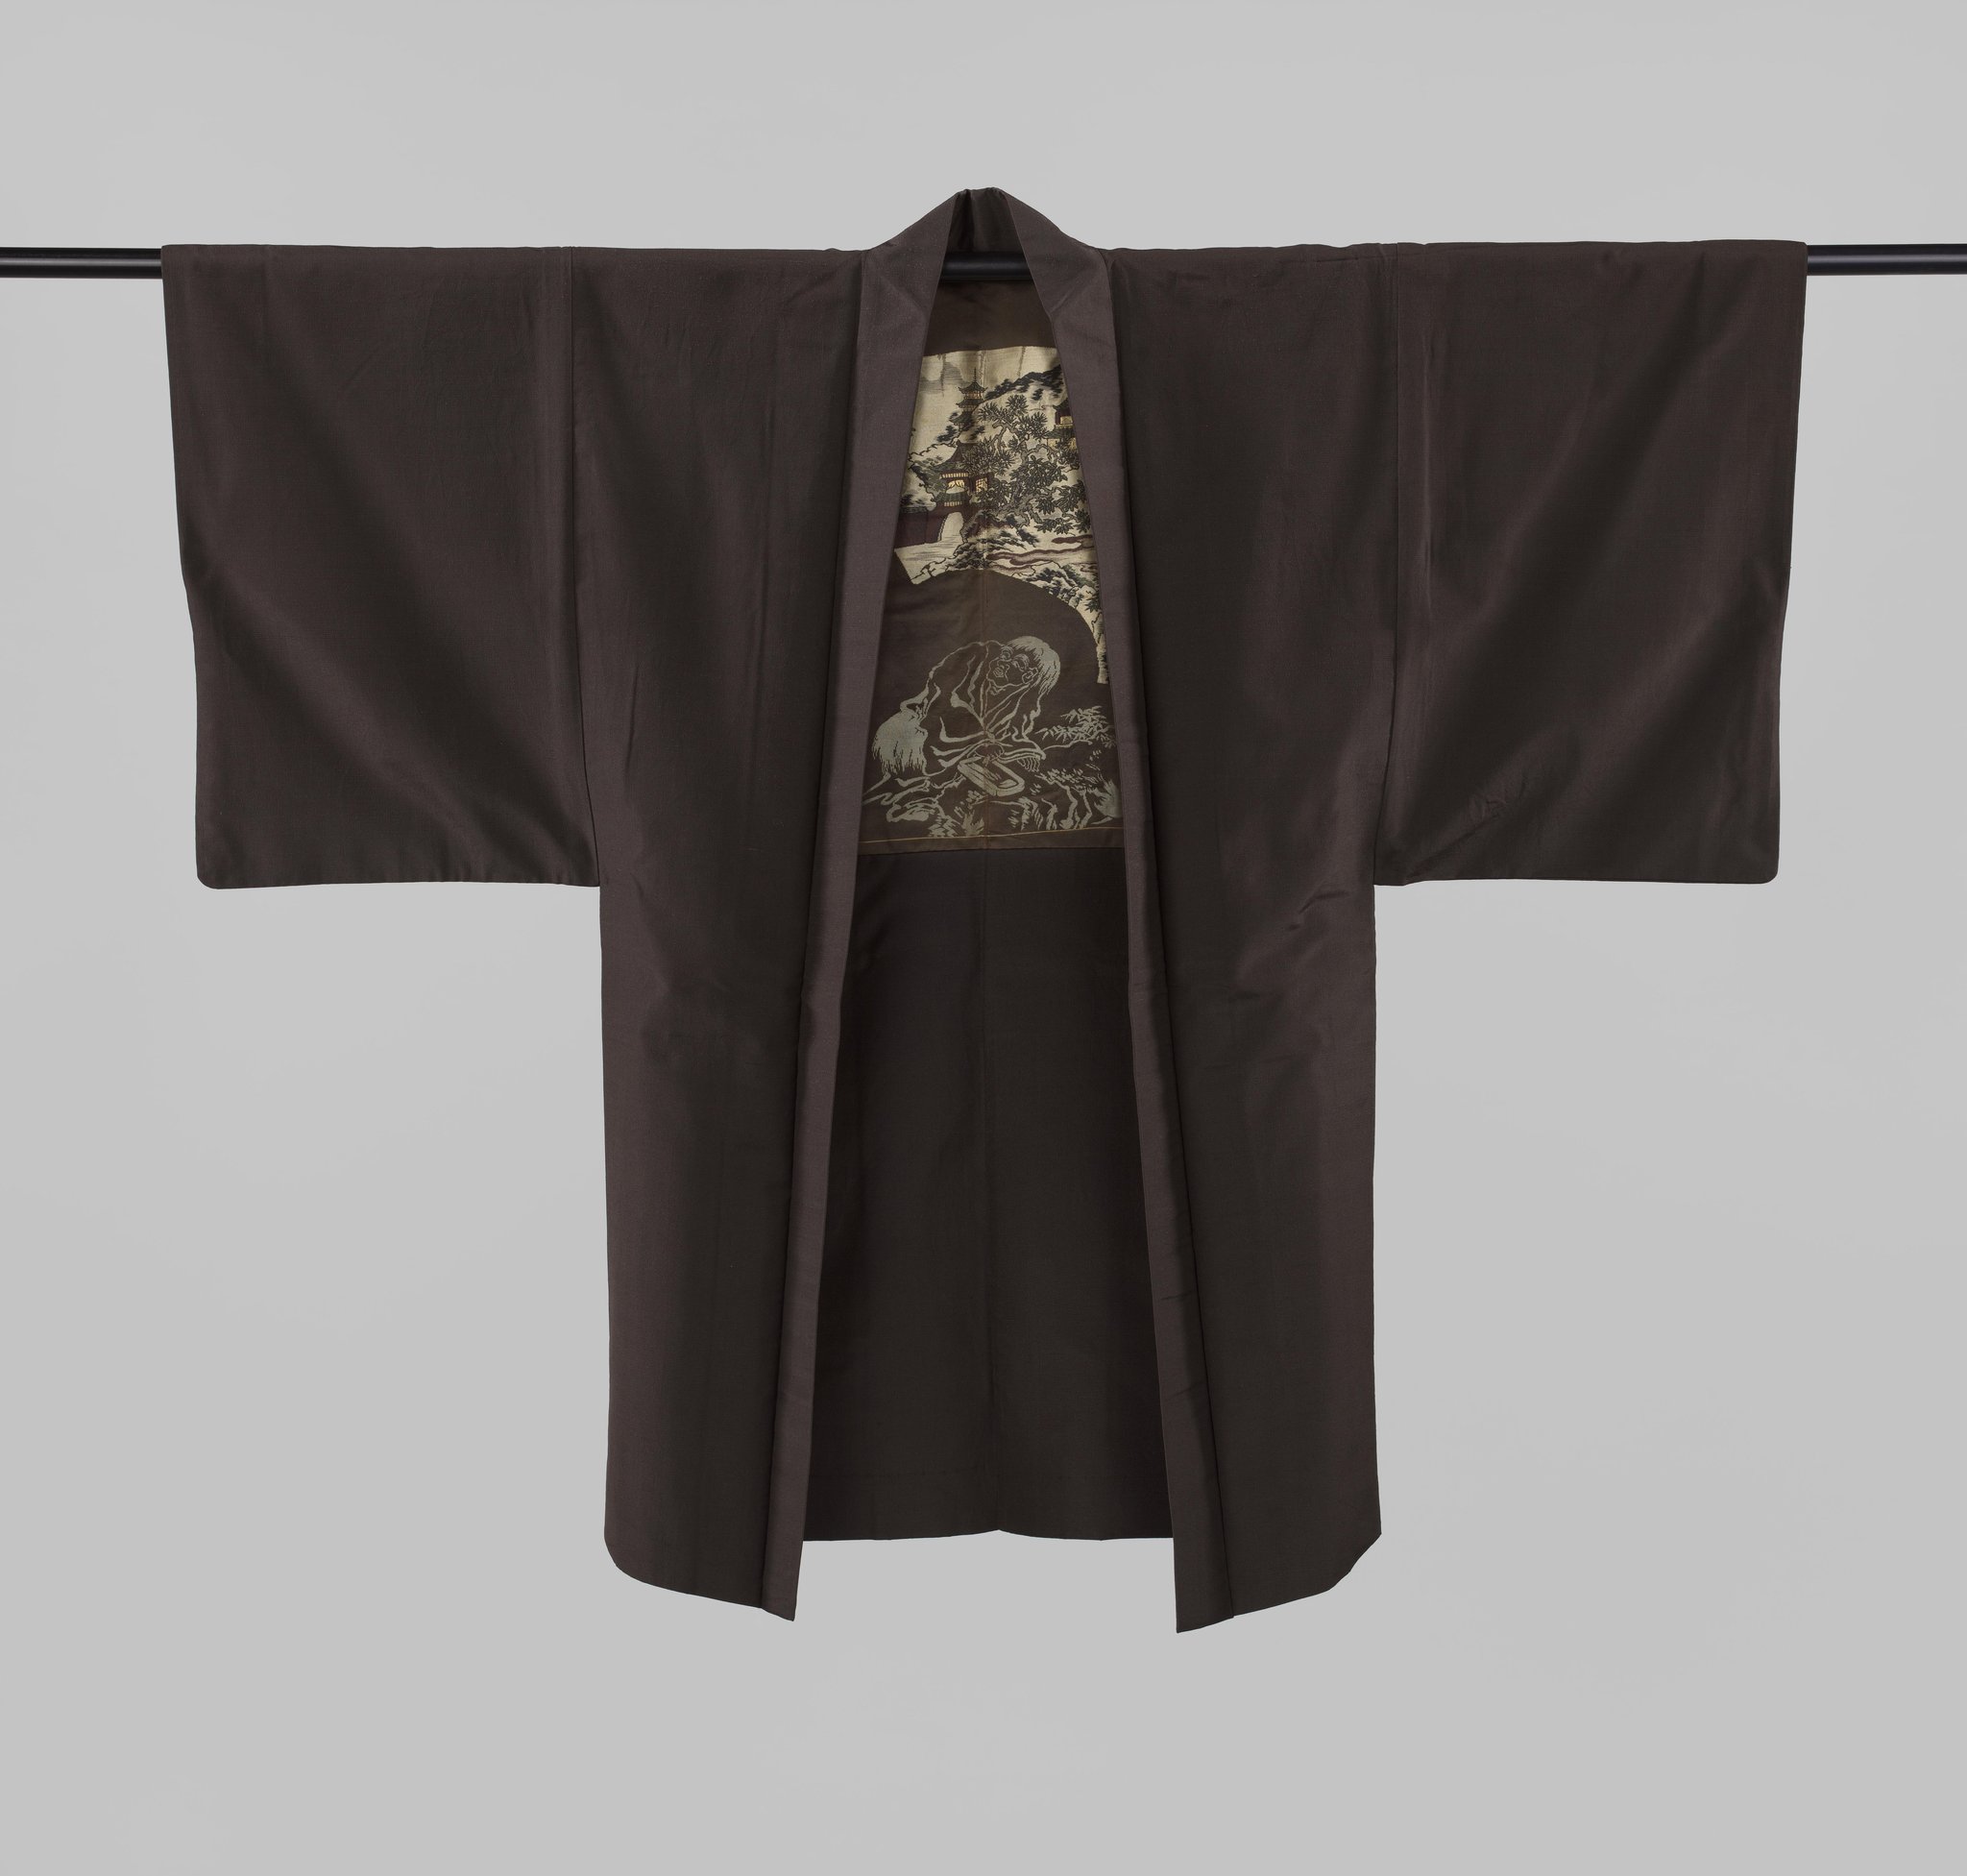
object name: kimono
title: Mannen haori met Wan Zixhi, Wan Xianzhi en het Orchidee Paviljoen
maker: Anonymous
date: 1920-1940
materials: silk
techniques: weave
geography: japan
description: Haori voor een man met een versiering op de voering van een landschap met paviljoens en een brug over een stroom in de bergen, in imitatie van een vouwwaaierschildering, met links daarvan twee figuren, de een (Xianzhi) inkt wrijvend in een inksteen op een rots, de ander (zijn vader, Zixhi) schrijvend met een penseel op een verticaal stuk rots. Wan Zixhi was een Chinese calligraaf uit de 4de eeuw, beroemd om zijn Lan Ting Xu, Voorwoord bij de verzameling gedichten geschreven in het Orchidee Paviljoen. Donkerbruine ruwe zijde (tsumugi) met brokaat geweven decoratie.